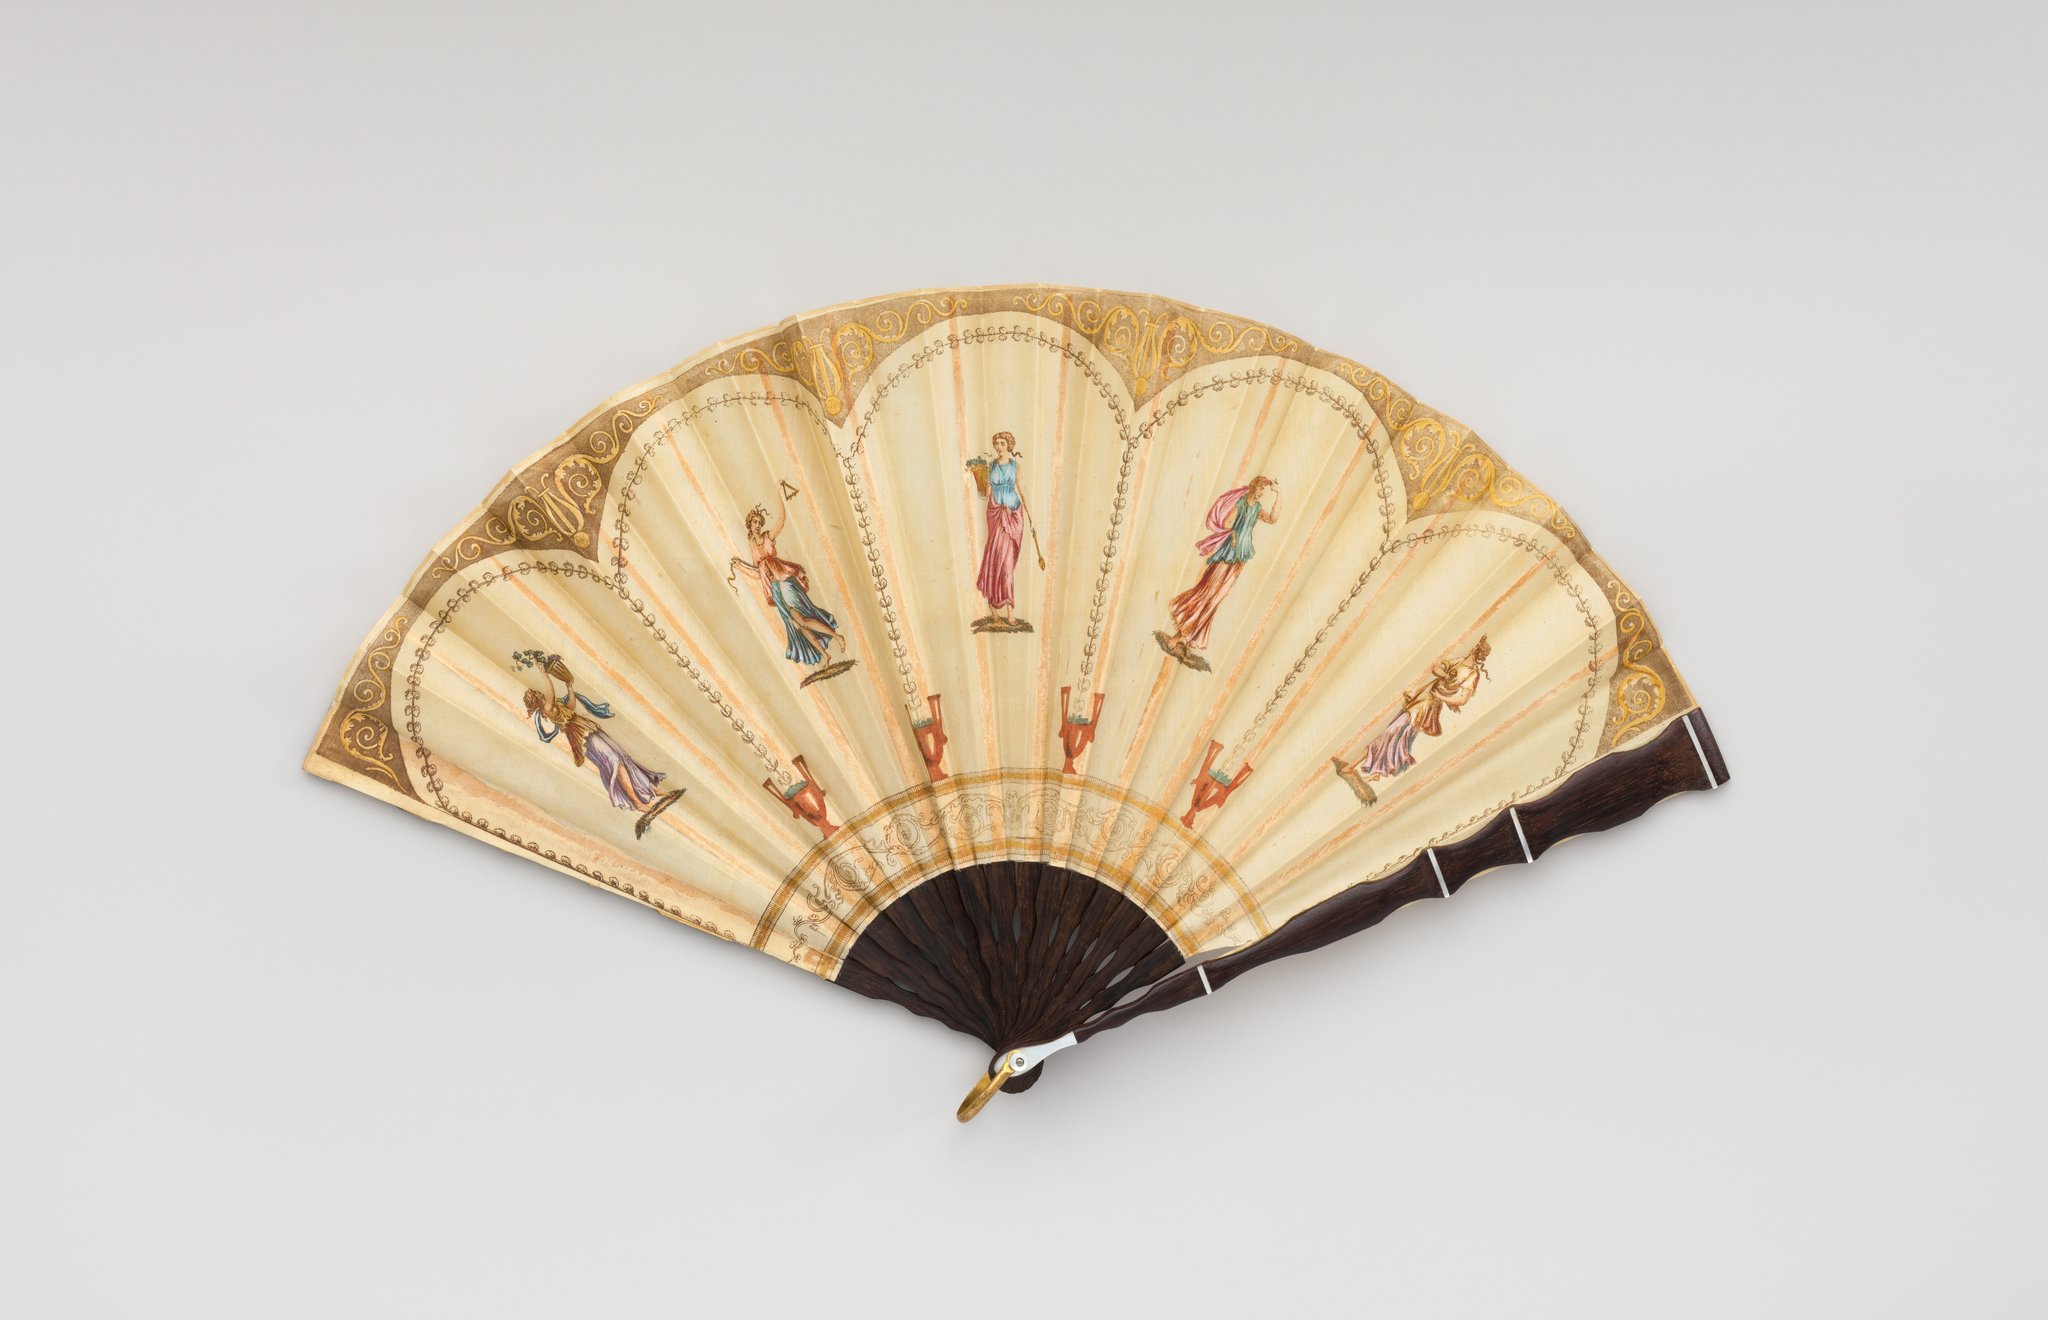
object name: fan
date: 1801-1900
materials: ivory, silk, wood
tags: women